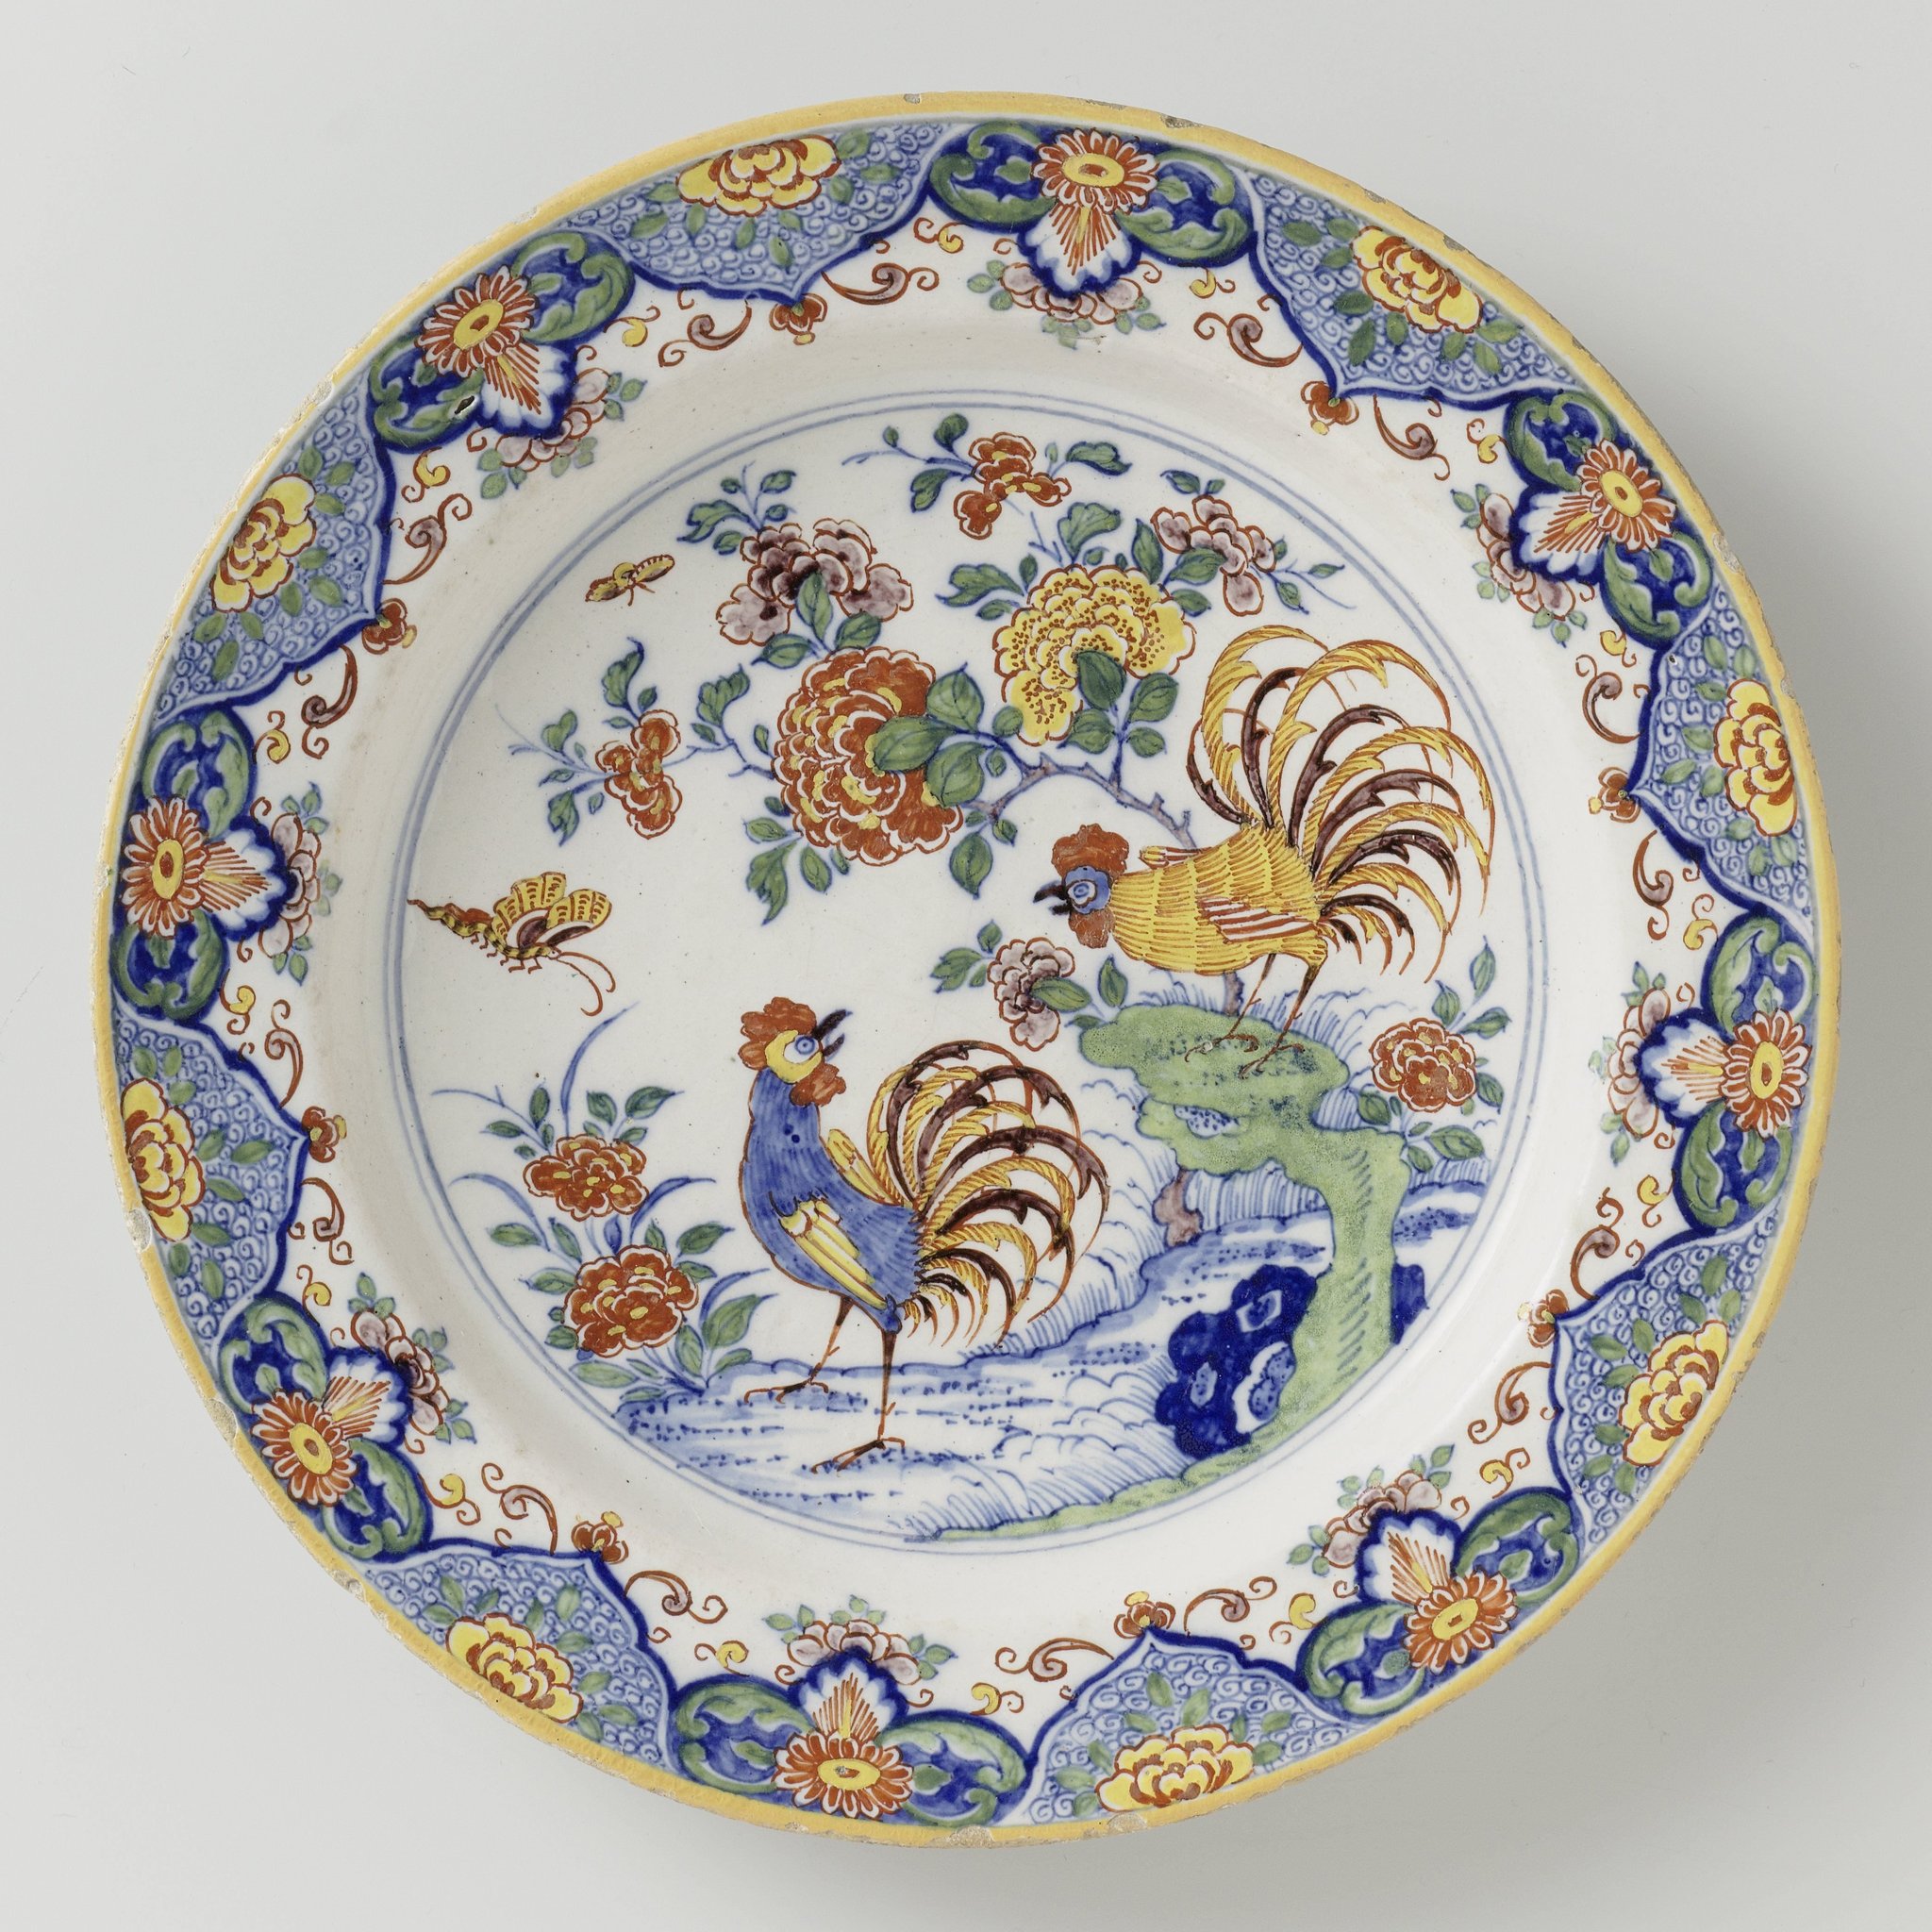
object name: plate dish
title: Bord, beschilderd met twee hanen en bloemen in een landschap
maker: Anonymous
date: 1752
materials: earthenware, glaze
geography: delft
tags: fowl (cock, hen, chicken, etc.), flowers ~ ornament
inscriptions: date: ‘1752’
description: Bord van faience, veelkleurig beschilderd met twe hanen en bloemen in een landschap.